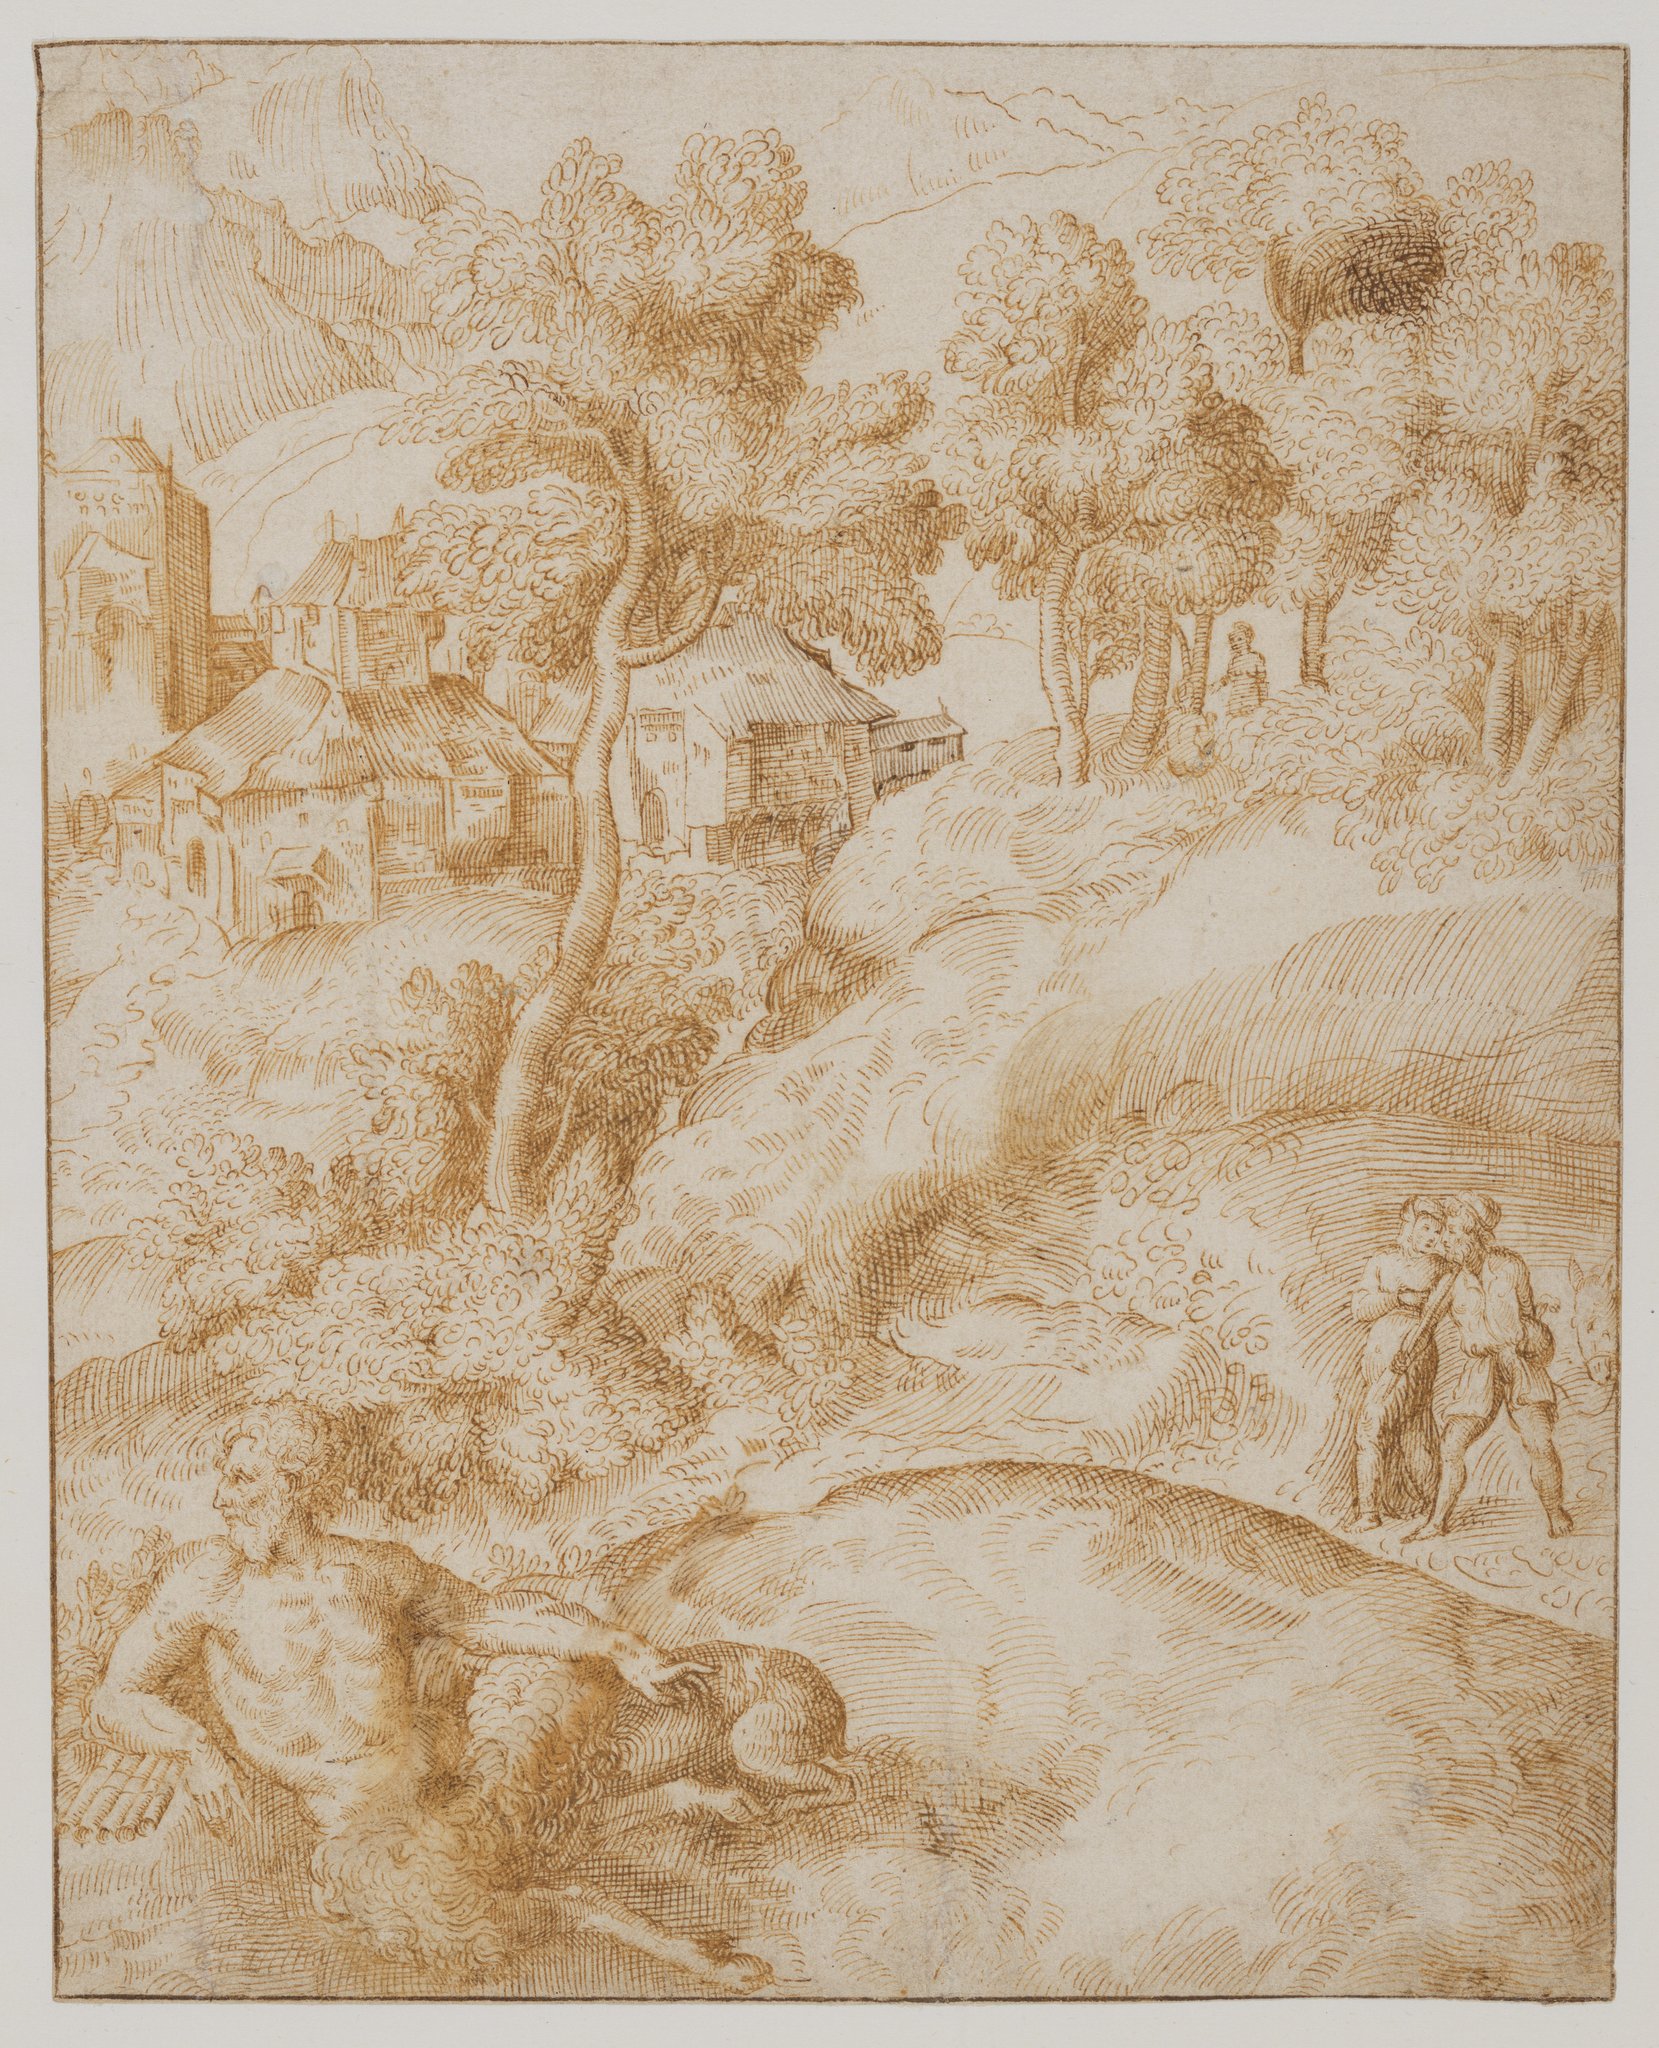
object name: drawing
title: Landscape with a Satyr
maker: domenico campagnola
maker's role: artist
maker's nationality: italian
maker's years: 1500-1564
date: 1535-1540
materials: ink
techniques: pen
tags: satyrs,landscapes